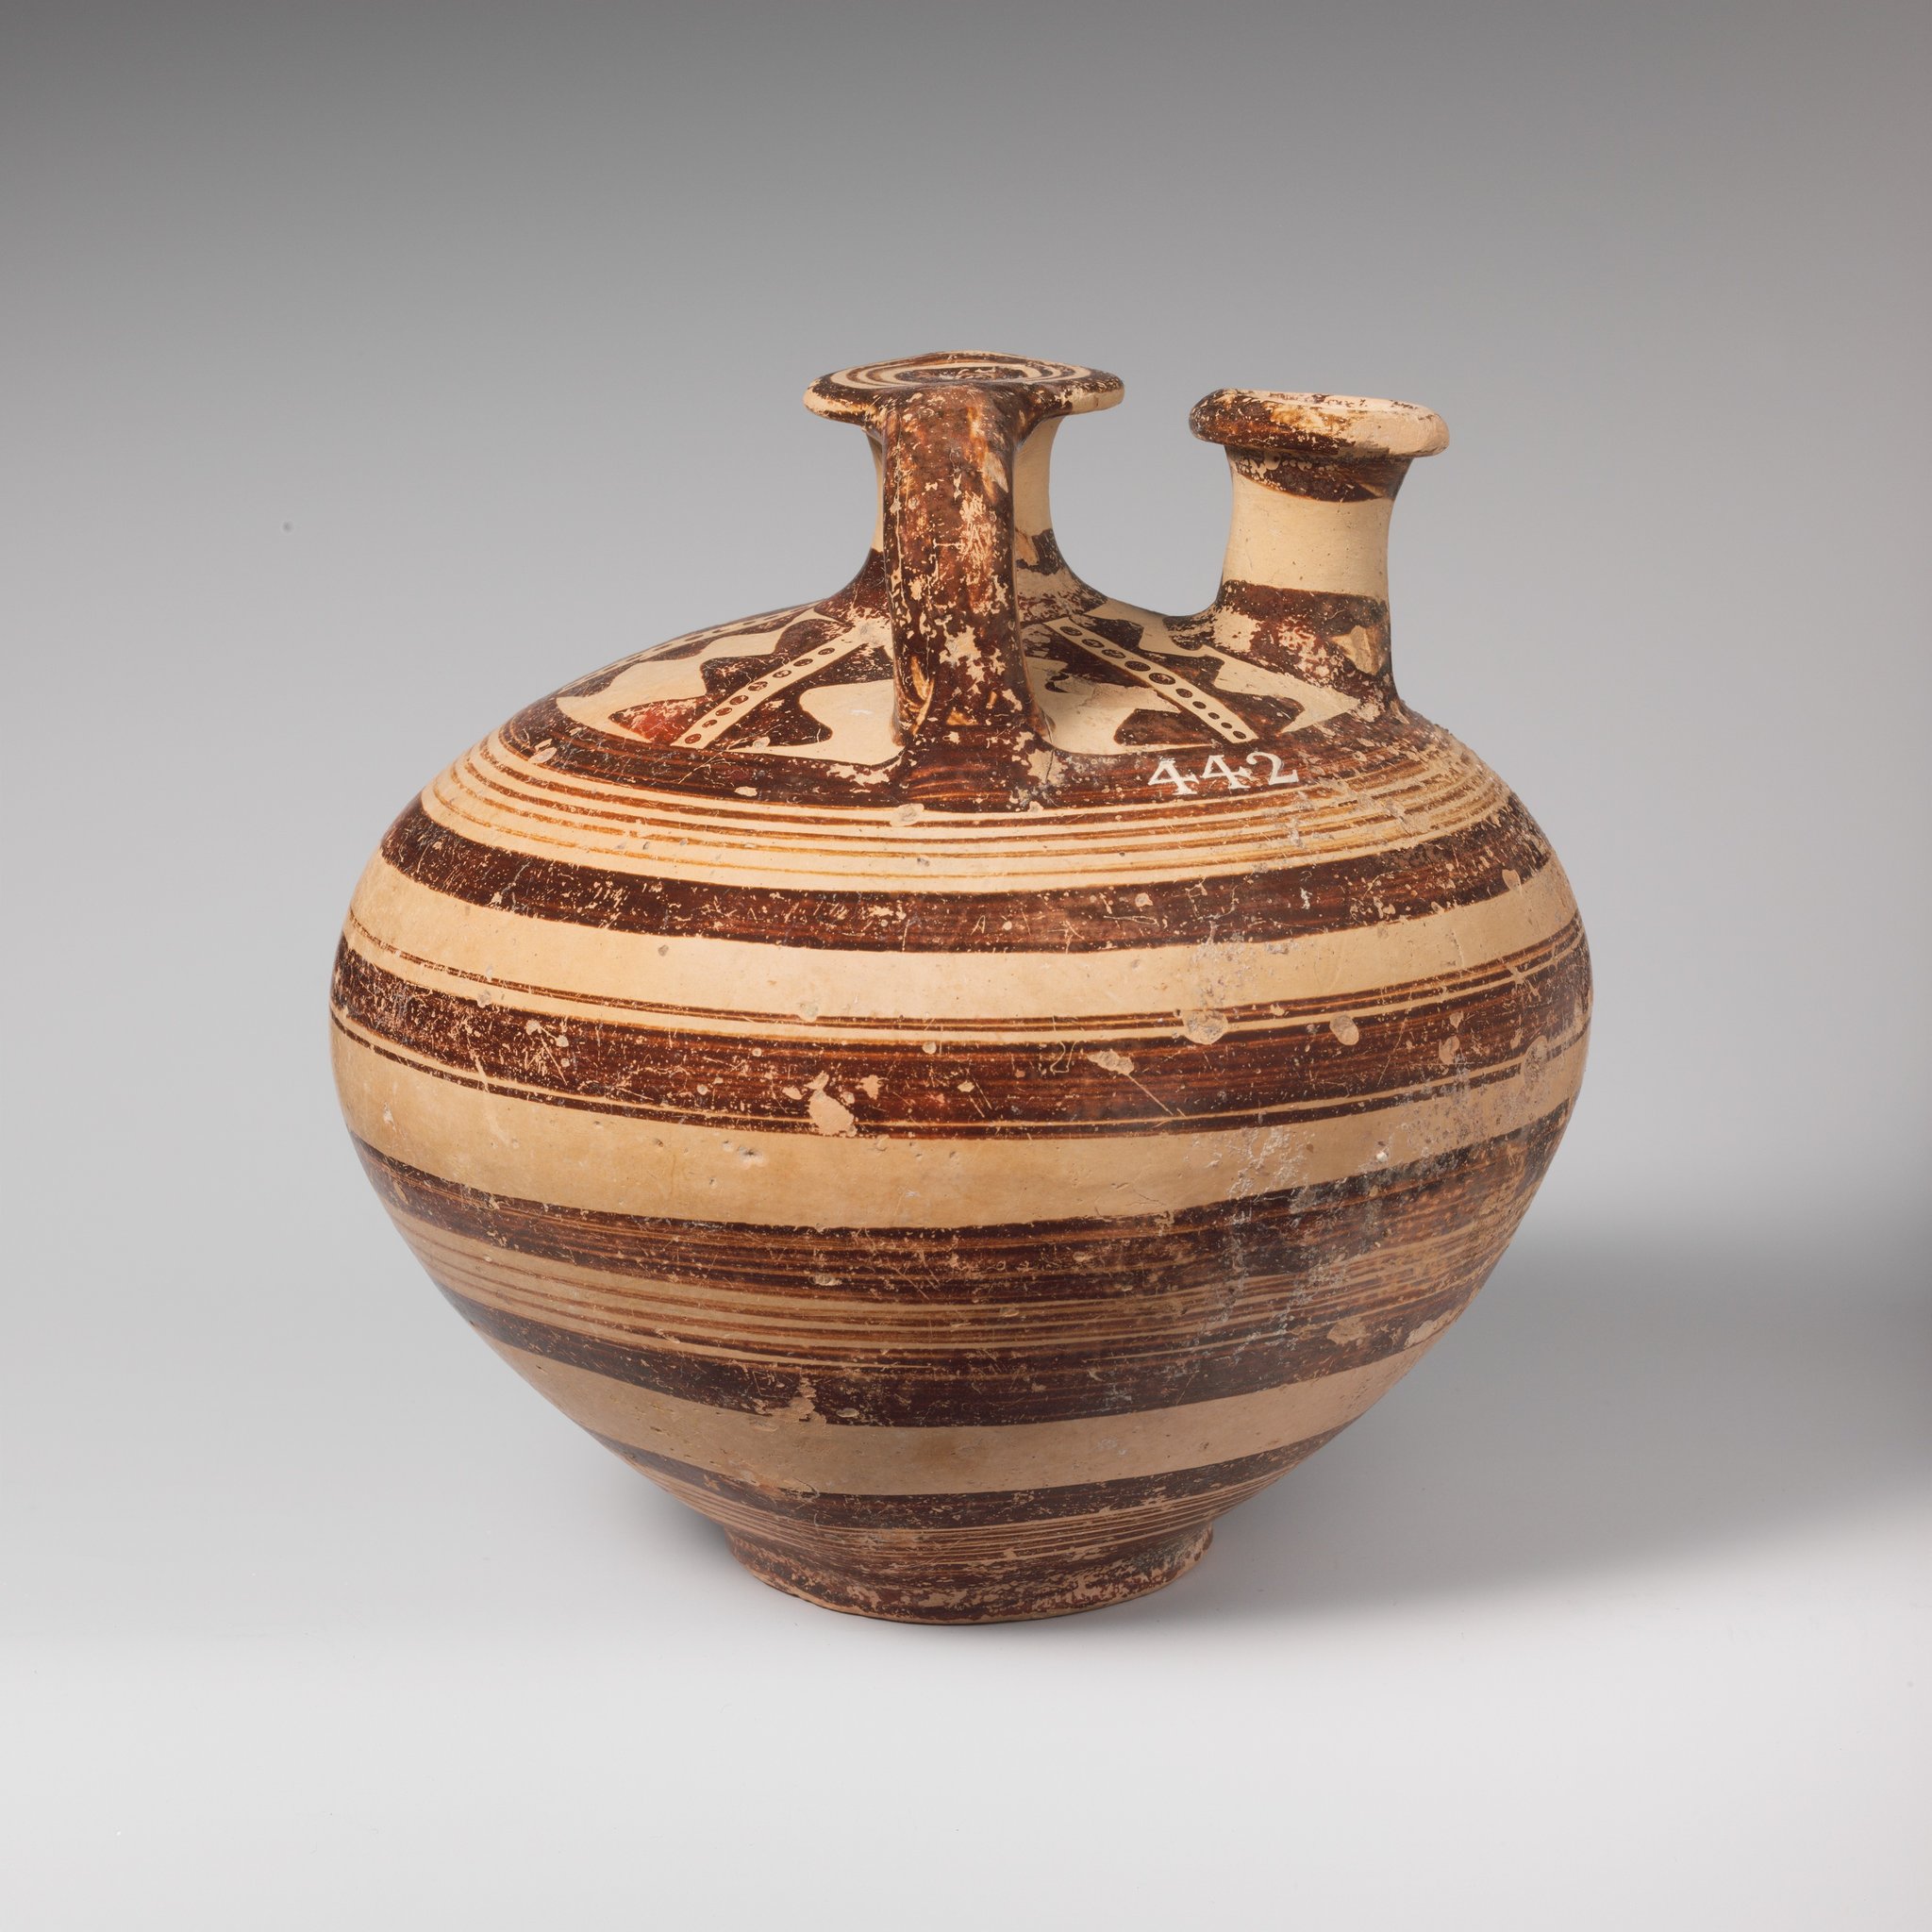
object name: false necked jar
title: Terracotta stirrup jar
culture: mycenaean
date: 1375-1300 BCE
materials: terracotta